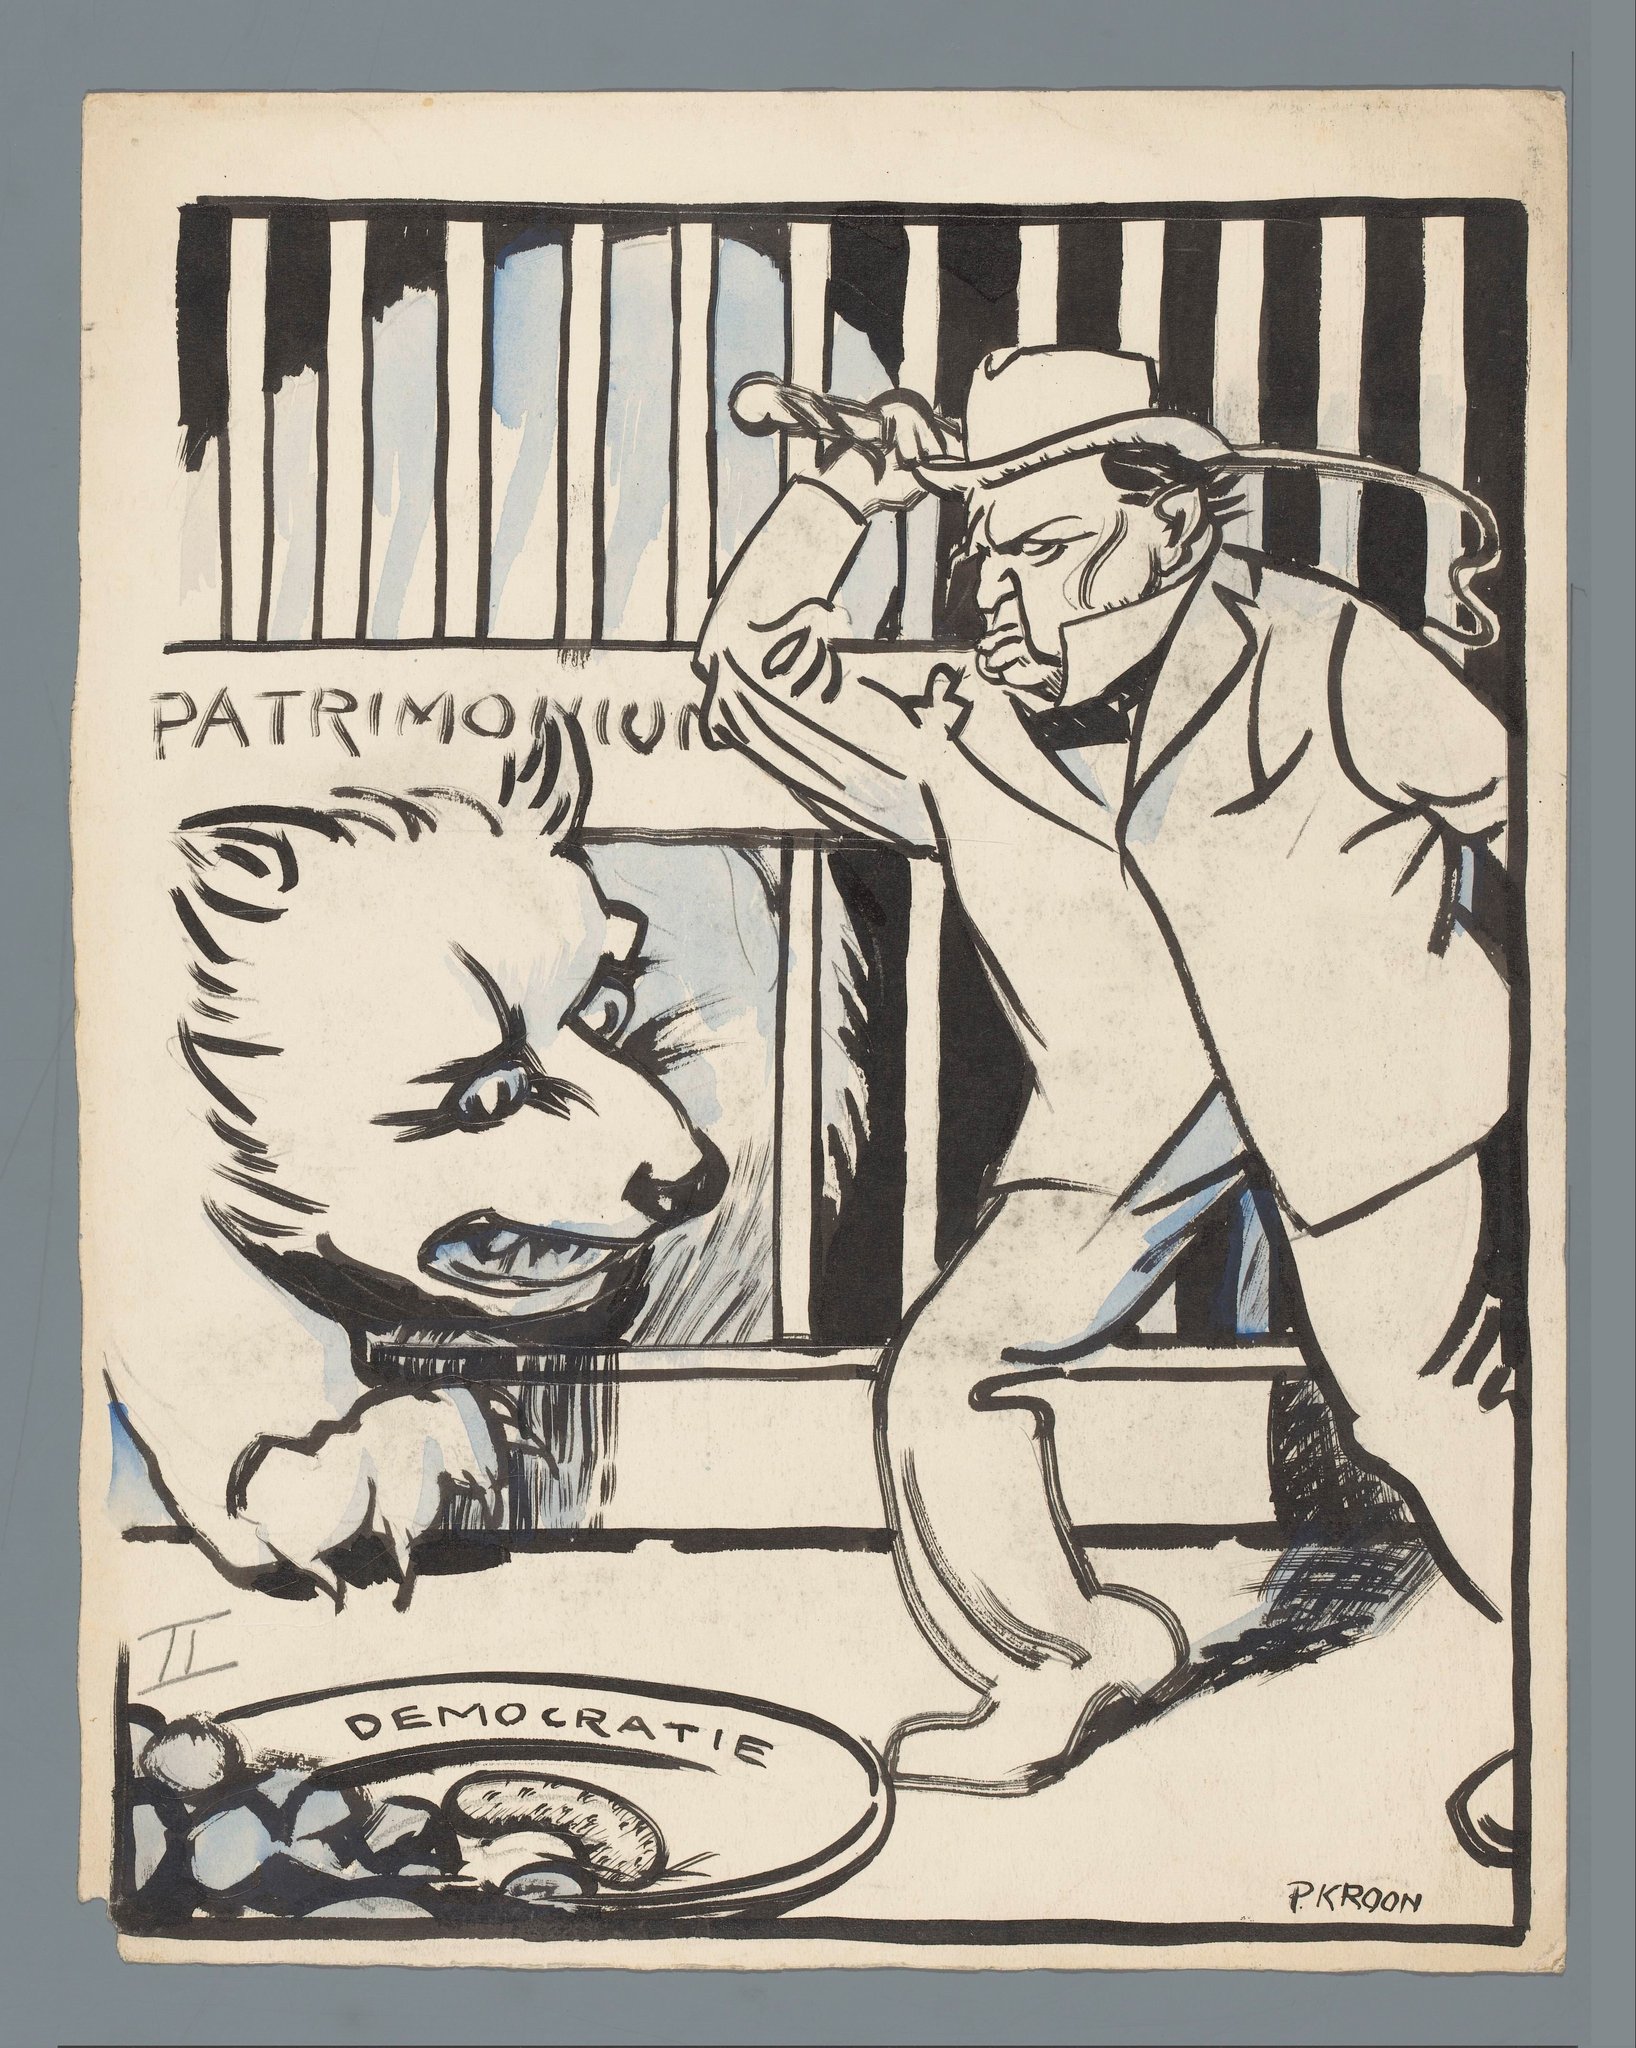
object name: cartoon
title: Het resultaat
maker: patricq kroon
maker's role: draughtsman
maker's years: 1862-1941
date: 1900-1920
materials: ink, paint, paper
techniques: brush, pen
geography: netherlands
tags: the hague, abraham kuyper, modern professional organization, trade union, beasts of prey, predatory animals: bear, political caricatures and satires, netherlands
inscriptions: inscription: ‘Het resultaat / Kuyper: Hok in! De zweep zal je wel mores leeren!’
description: Abraham Kupyer probeert met een zweep de beer die ontsnapt uit de kooi aangeduid als 'Patrimonium' terug te drijven. Naar aanleiding van het conflict tussen Kuyper en het Nederlandsch Werkliedenverbond Patrimonium. Op de achterzijde van het blad een portret van een man met pet. Ontwerp voor een politieke spotprent.